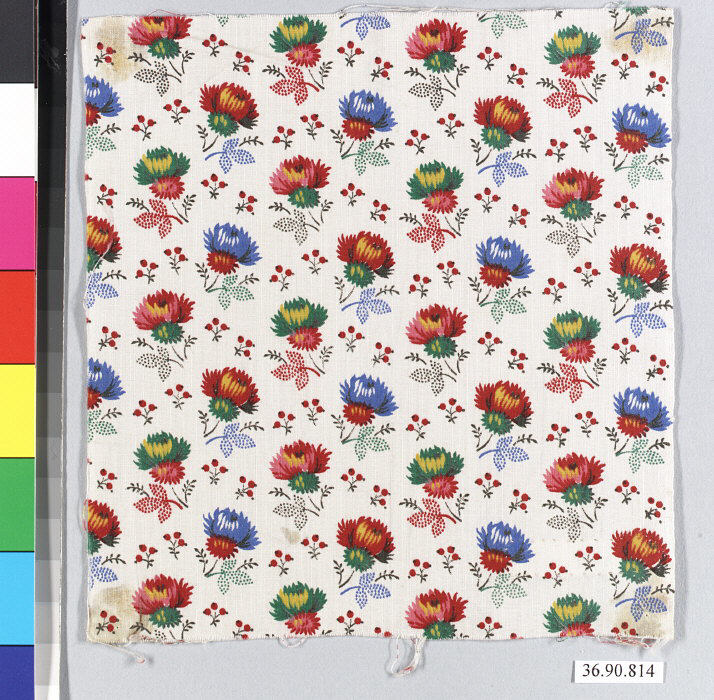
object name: piece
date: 1867-1900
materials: cotton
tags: flowers